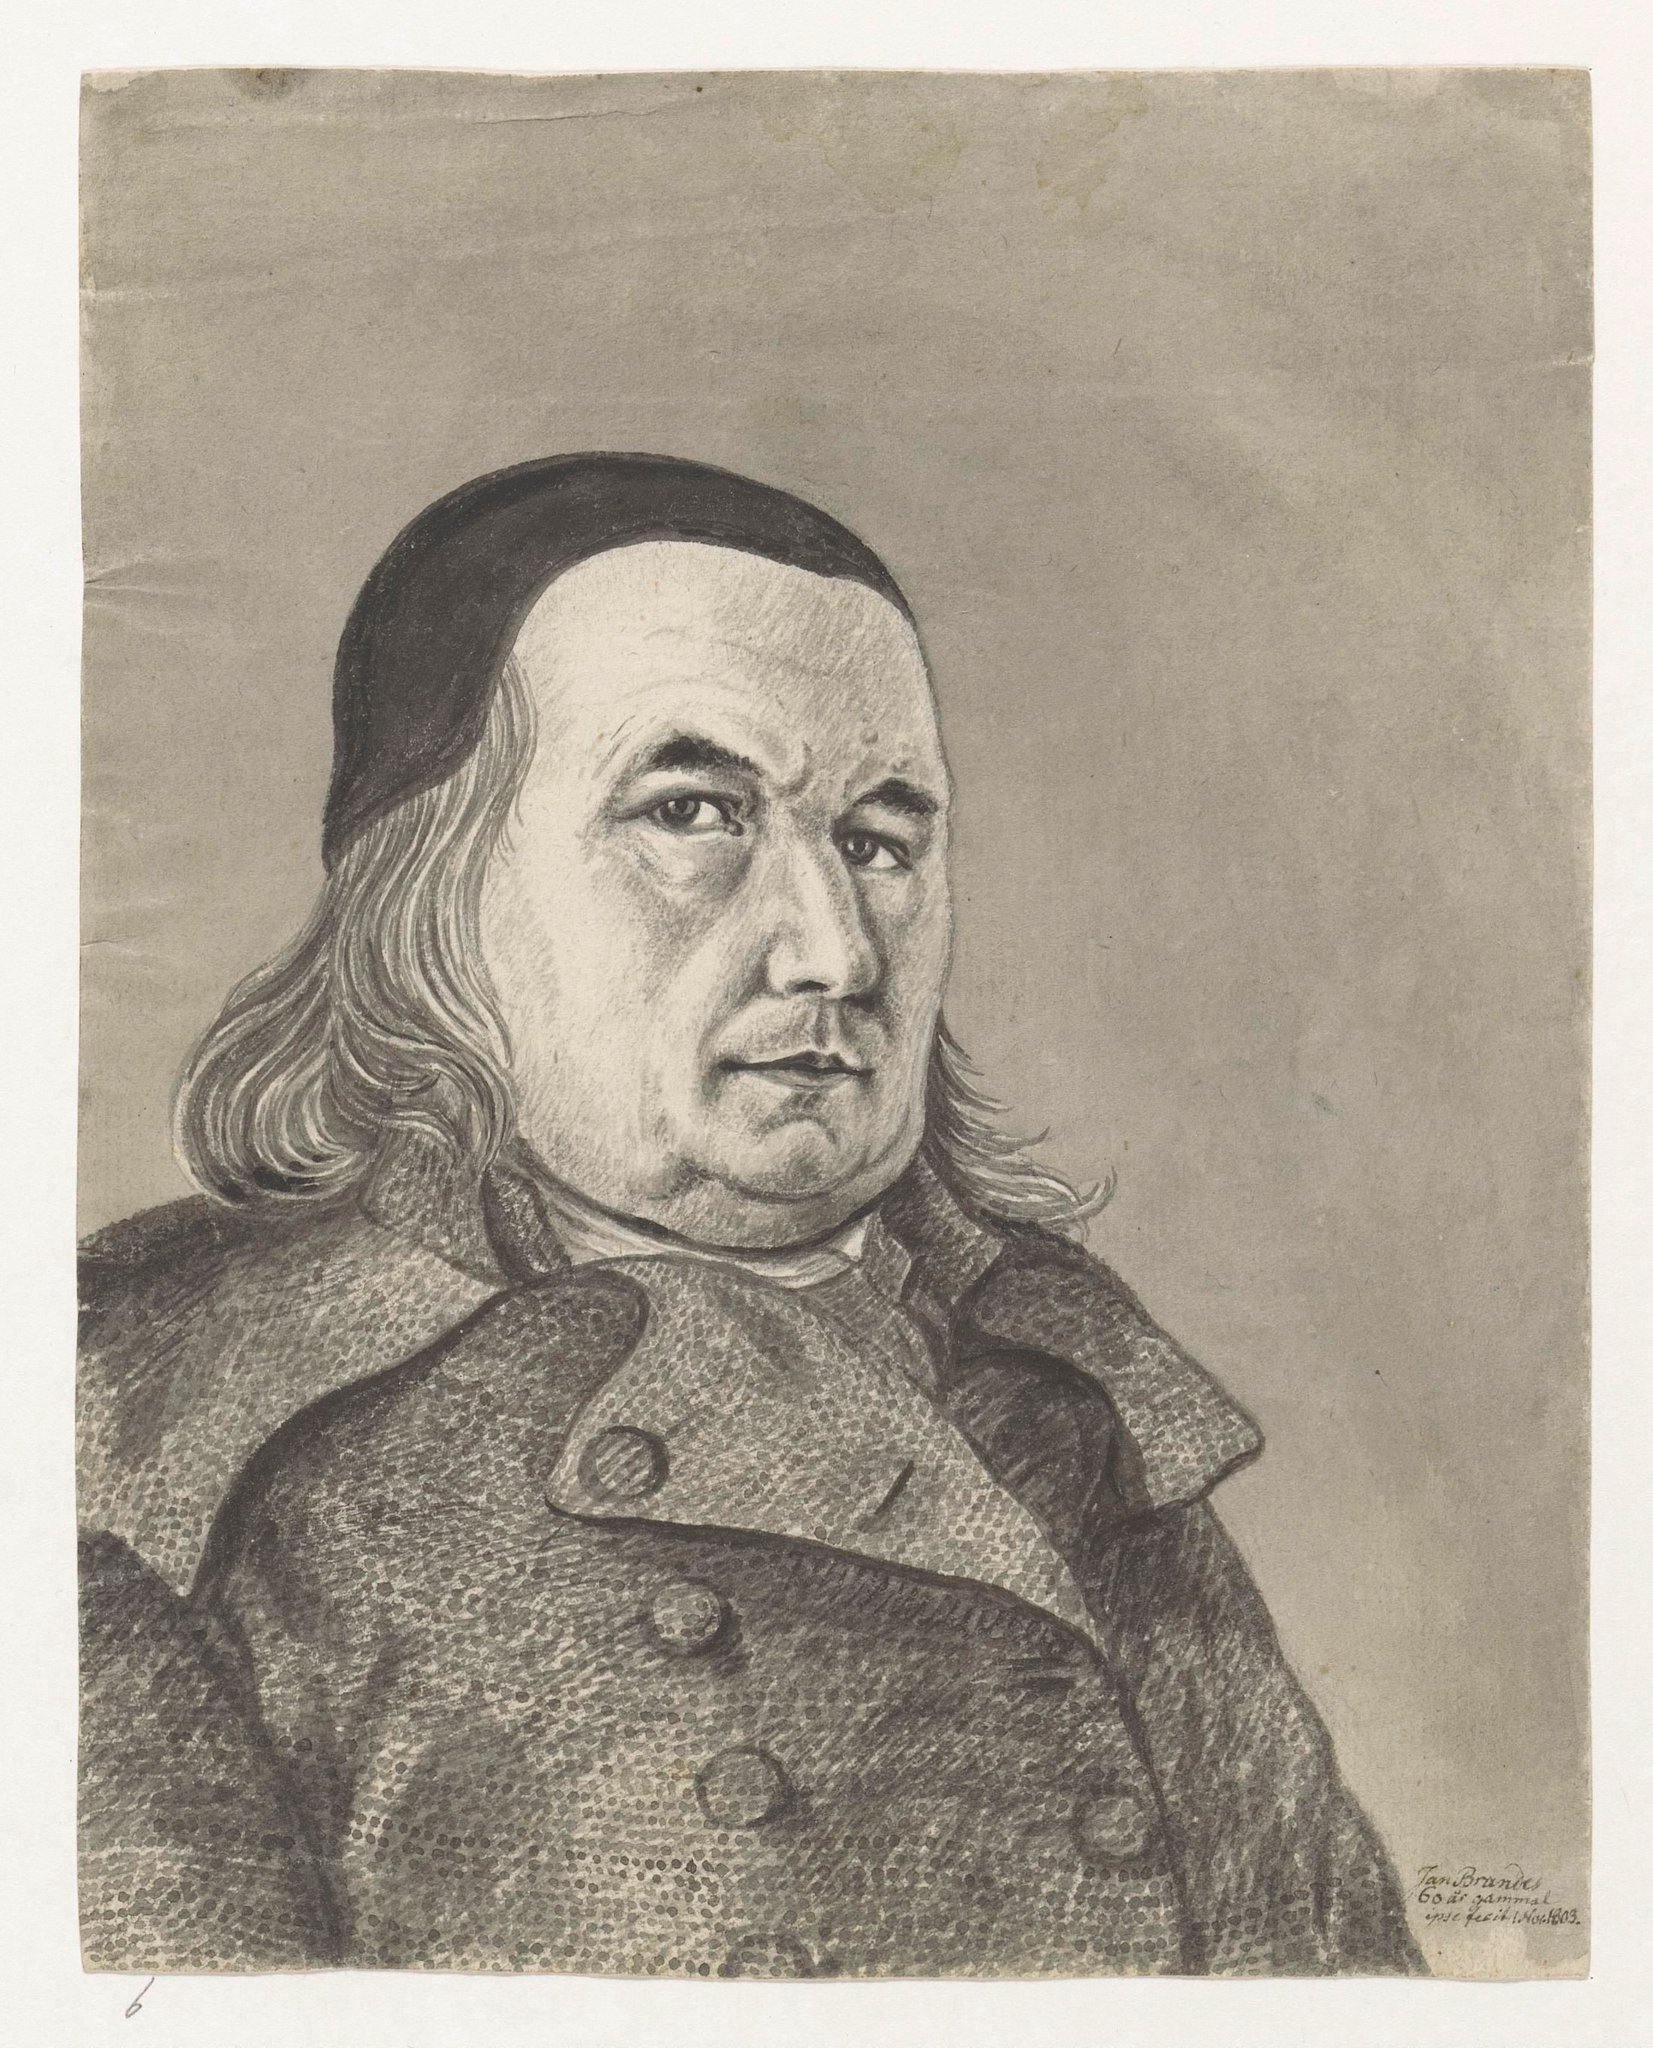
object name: drawing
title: Zelfportret van Jan Brandes 1803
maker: jan brandes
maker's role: draughtsman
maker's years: 1743-1808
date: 1803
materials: ink, paper, pencil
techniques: brush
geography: skälsebo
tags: bodegraven, draughtsman, jan brandes, historical persons, portrait, self-portrait of artist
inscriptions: inscription: ‘Jan Brandes 60 är gammal ipse fecit 1 Nov 1803’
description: Zelfportret van Jan Brandes uit 1803. Borstbeeld. Brandes draagt een soort muts en een zware dubbelsluitende overjas met schouderkleppen. Met opschrift.